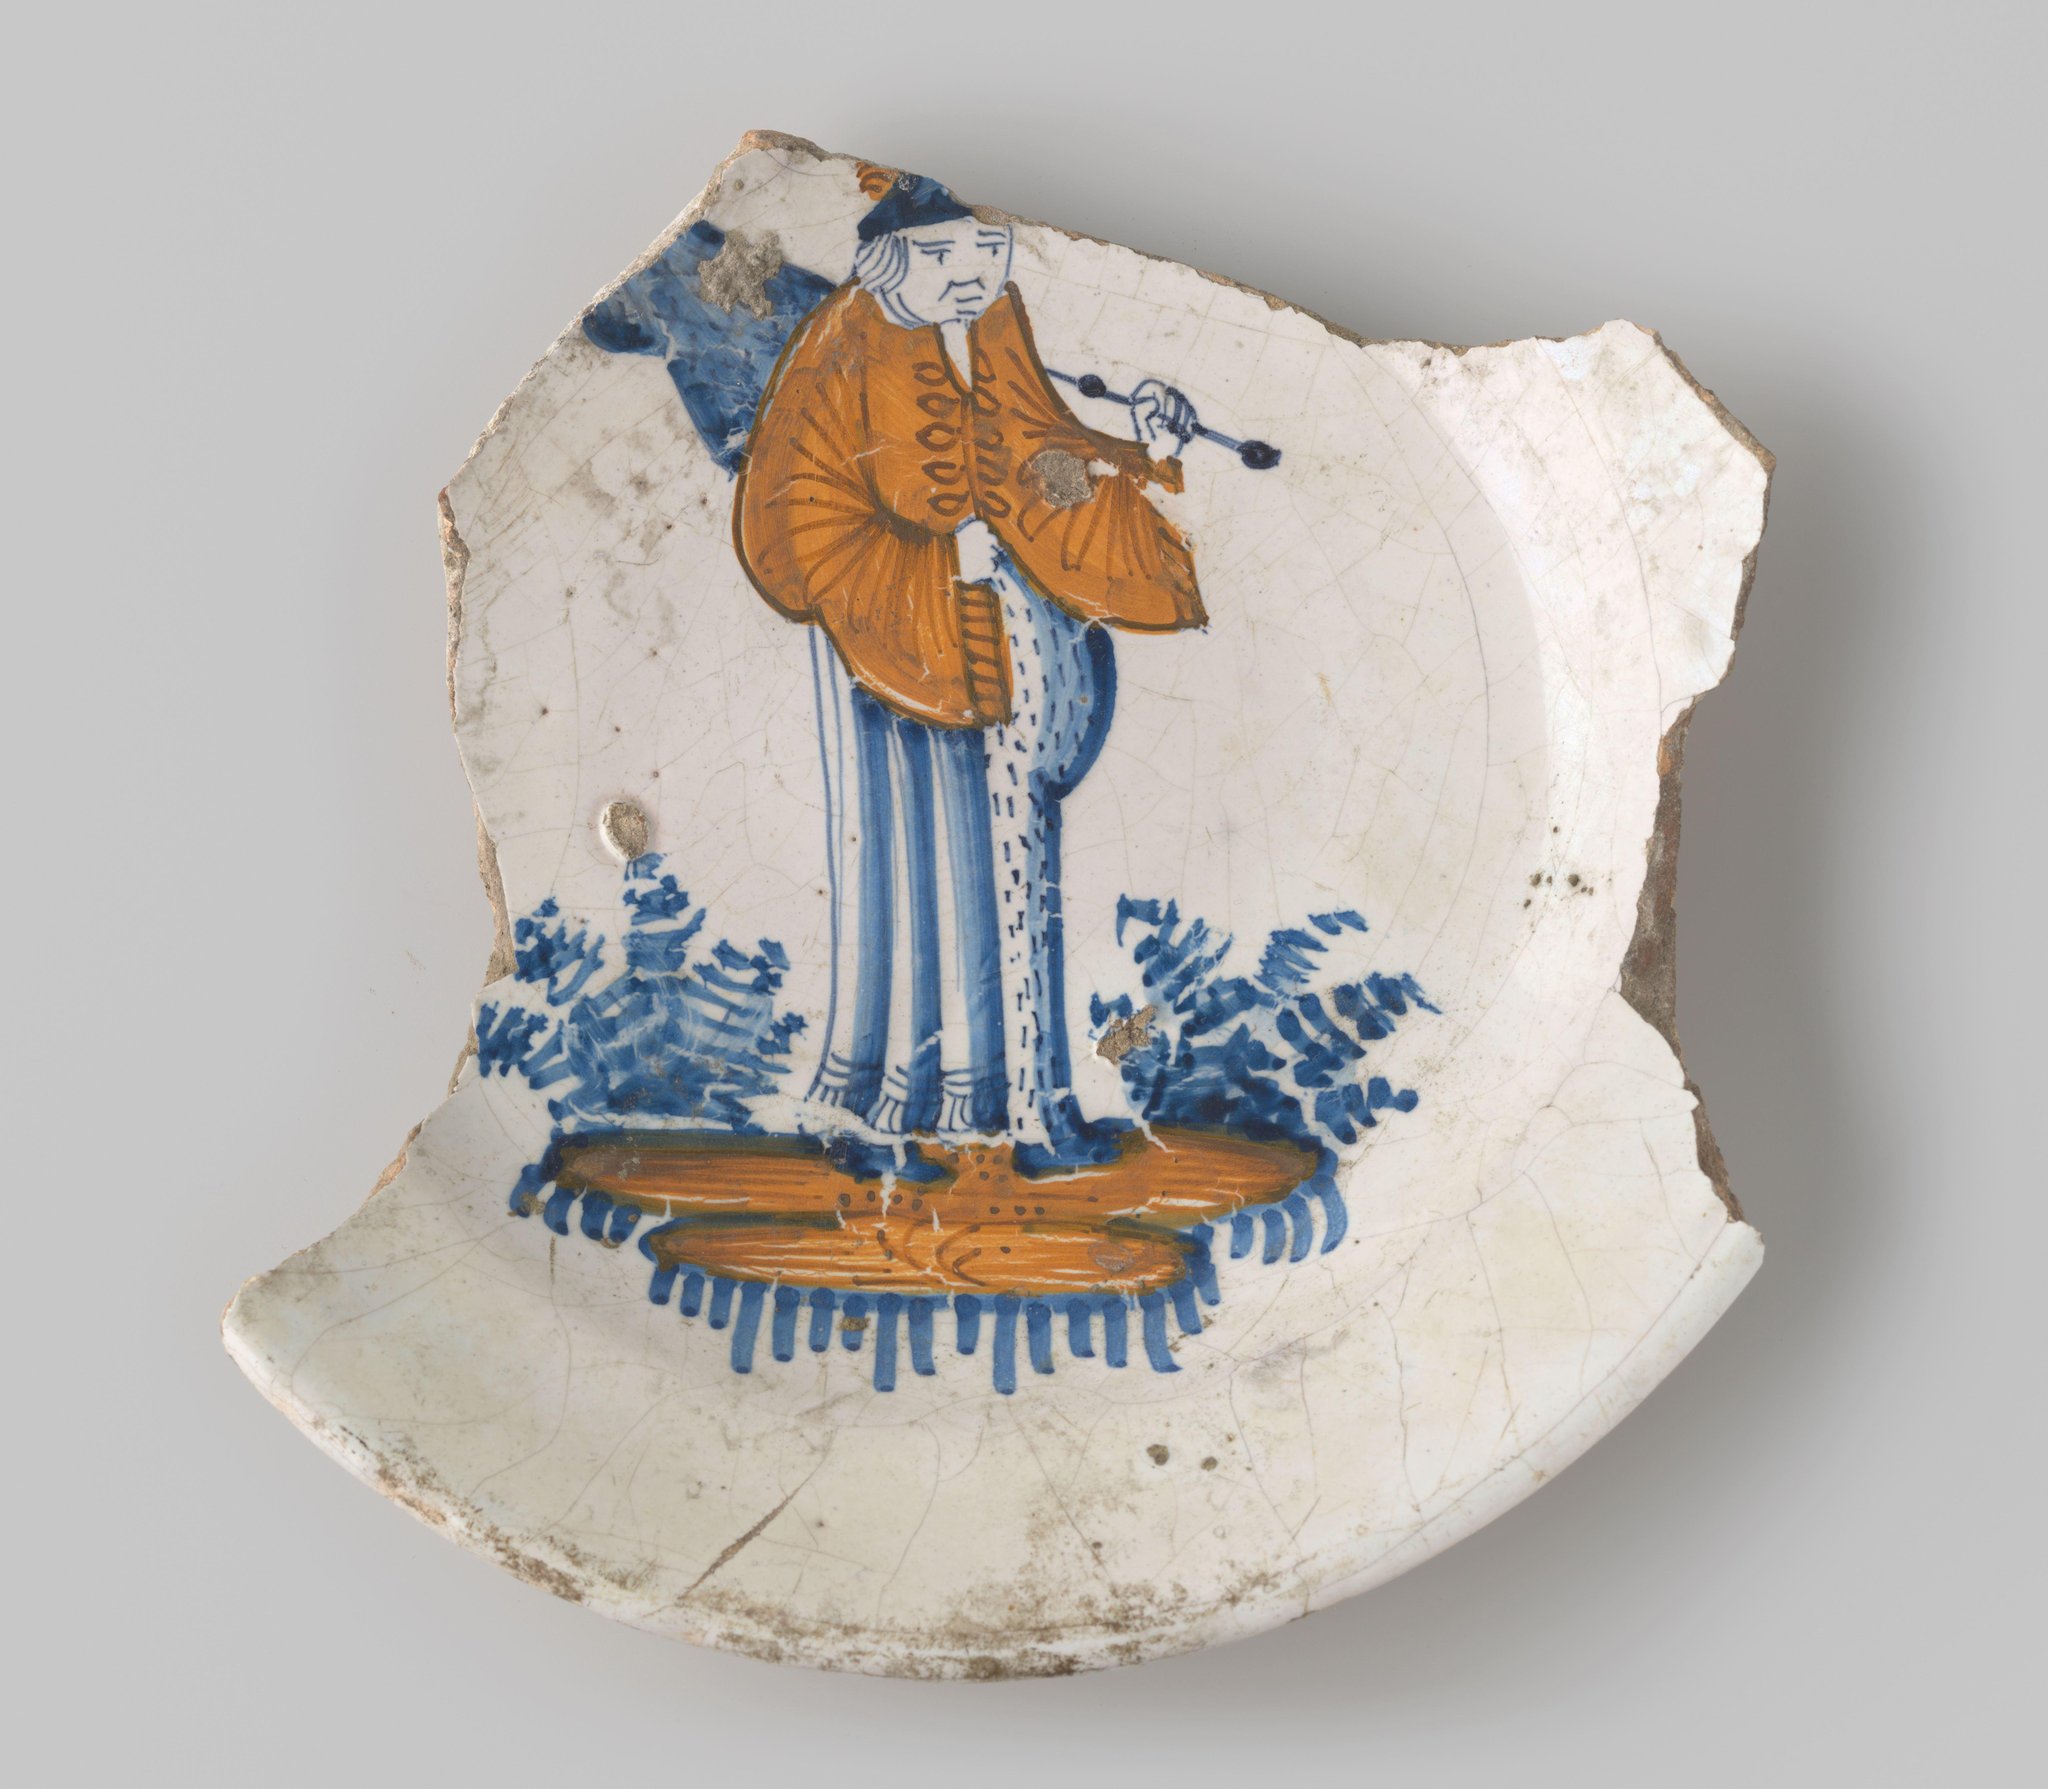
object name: fragment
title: Fragment van een schotel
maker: Anonymous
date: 1600-1625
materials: earthenware, glaze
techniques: maiolica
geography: northern netherlands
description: Fragment van een schotel op een lage voetring. Lichtrode scherf bedekt met tinglazuur aan de voorzijde en loodglazuur aan de achterzijde. Beschilderd in blauw en oranje met een Chinees met vlag over de linkerschouder op een grondje.